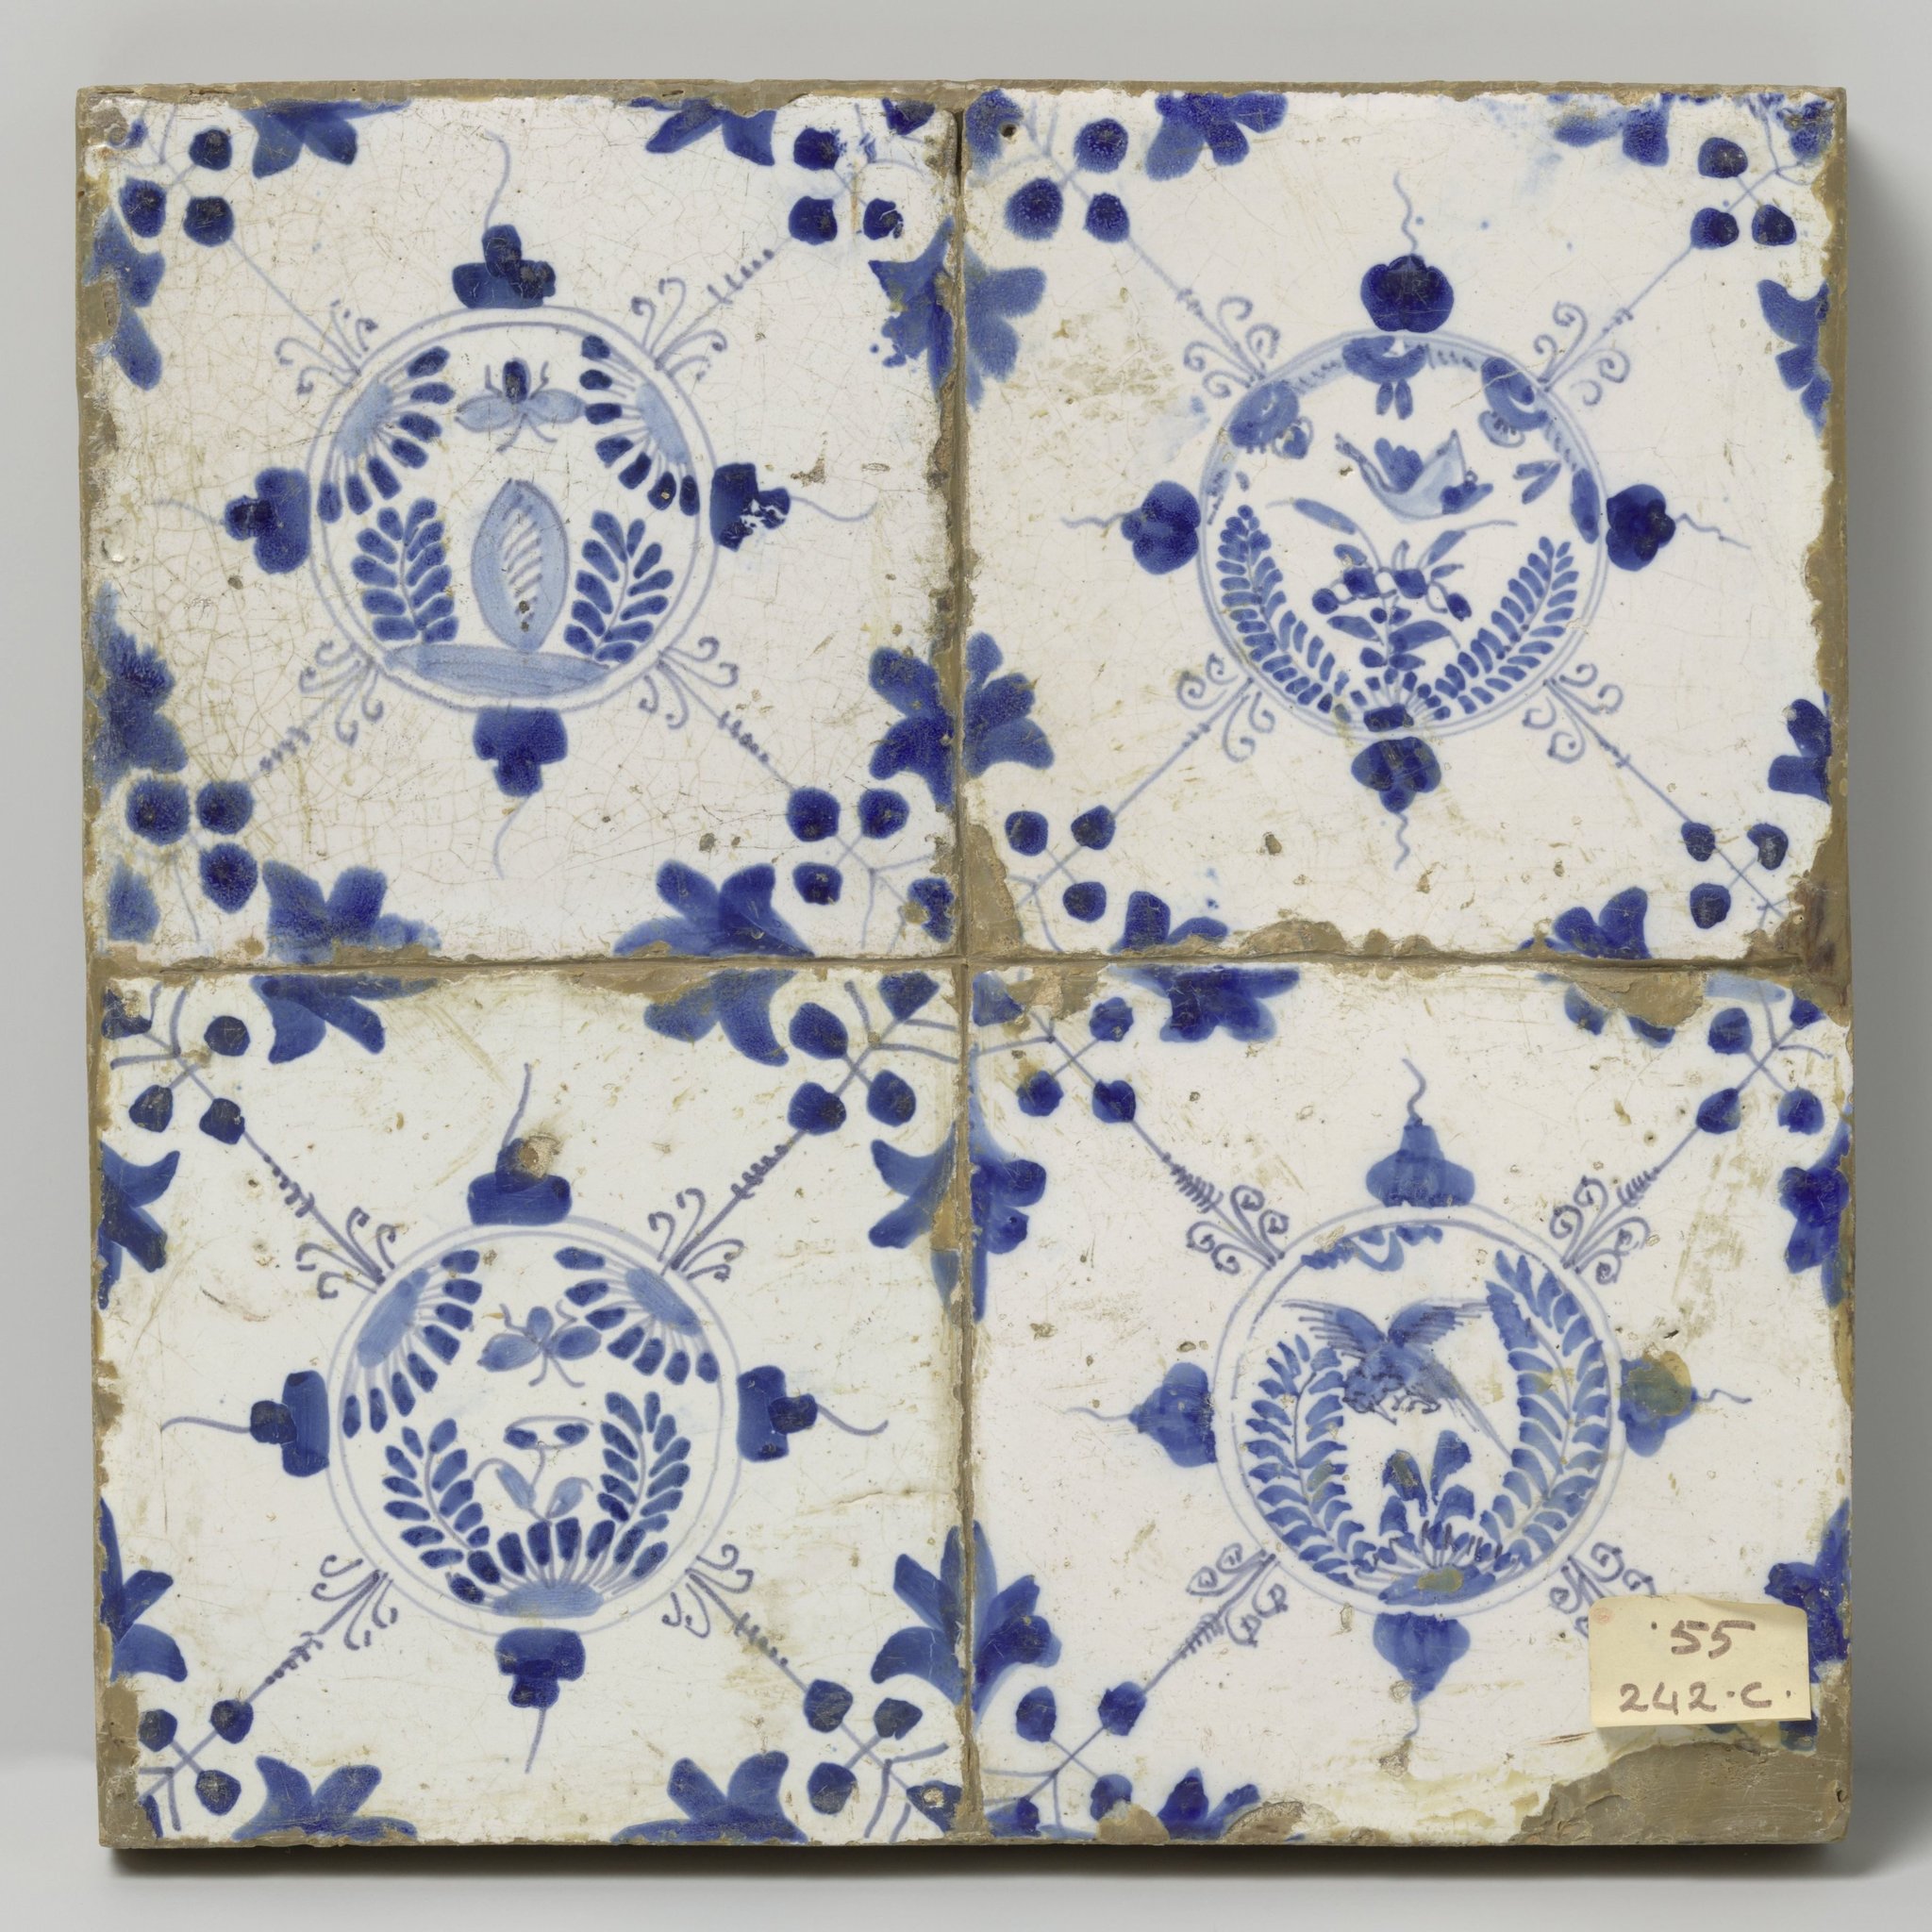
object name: tegelveld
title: Veld van vier tegels met vlinders en vogels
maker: Anonymous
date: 1620-1640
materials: earthenware, glaze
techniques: maiolica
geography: netherlands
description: Veld van vier tegels (2 x 2) elk met een blauw geschilderde vlinder of vogel in een Chinese tuin binnen een cirkel. In de hoeken, een driestip.